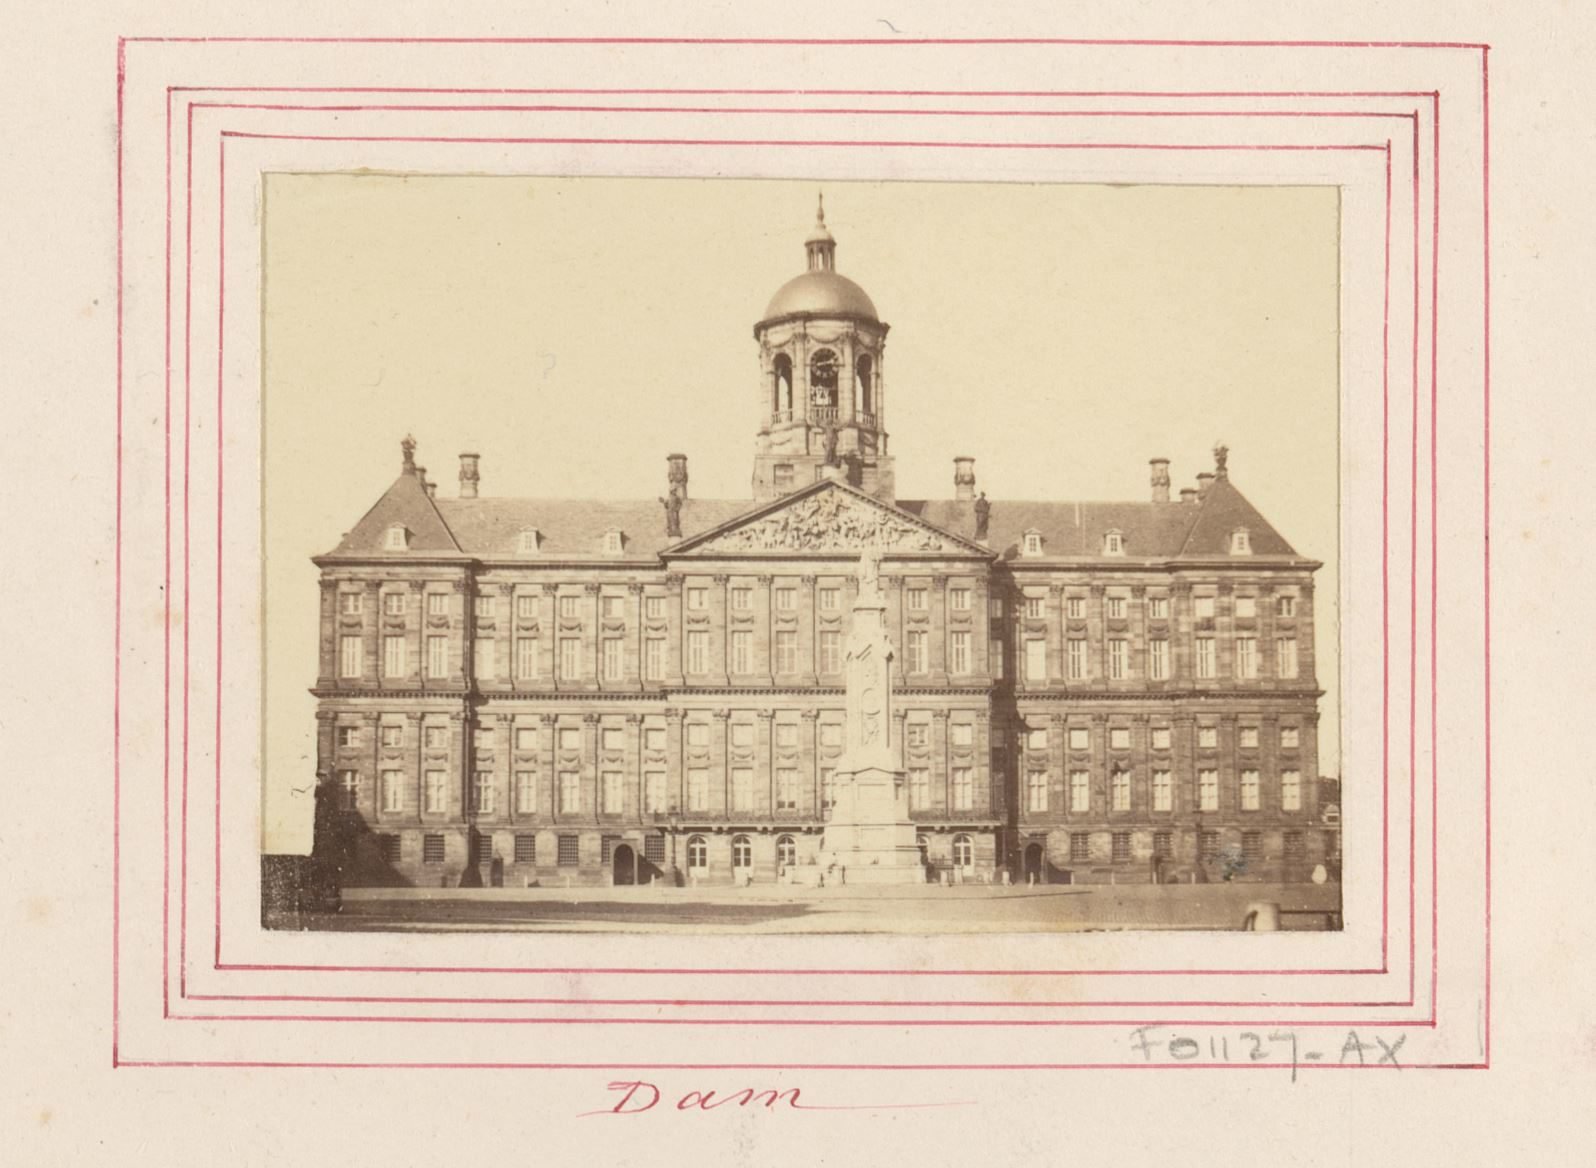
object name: photograph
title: Exterieur van het Paleis op de Dam in Amsterdam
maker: Anonymous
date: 1870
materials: photographic support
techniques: albumen print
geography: dam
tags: palace, monument, statue, façade (of house or building), royal palace of amsterdam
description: Onderdeel van Album met foto's en litho's van bezienswaardigheden in Noord- en Zuid-Hollandse steden, schilderijen en klederdrachten.